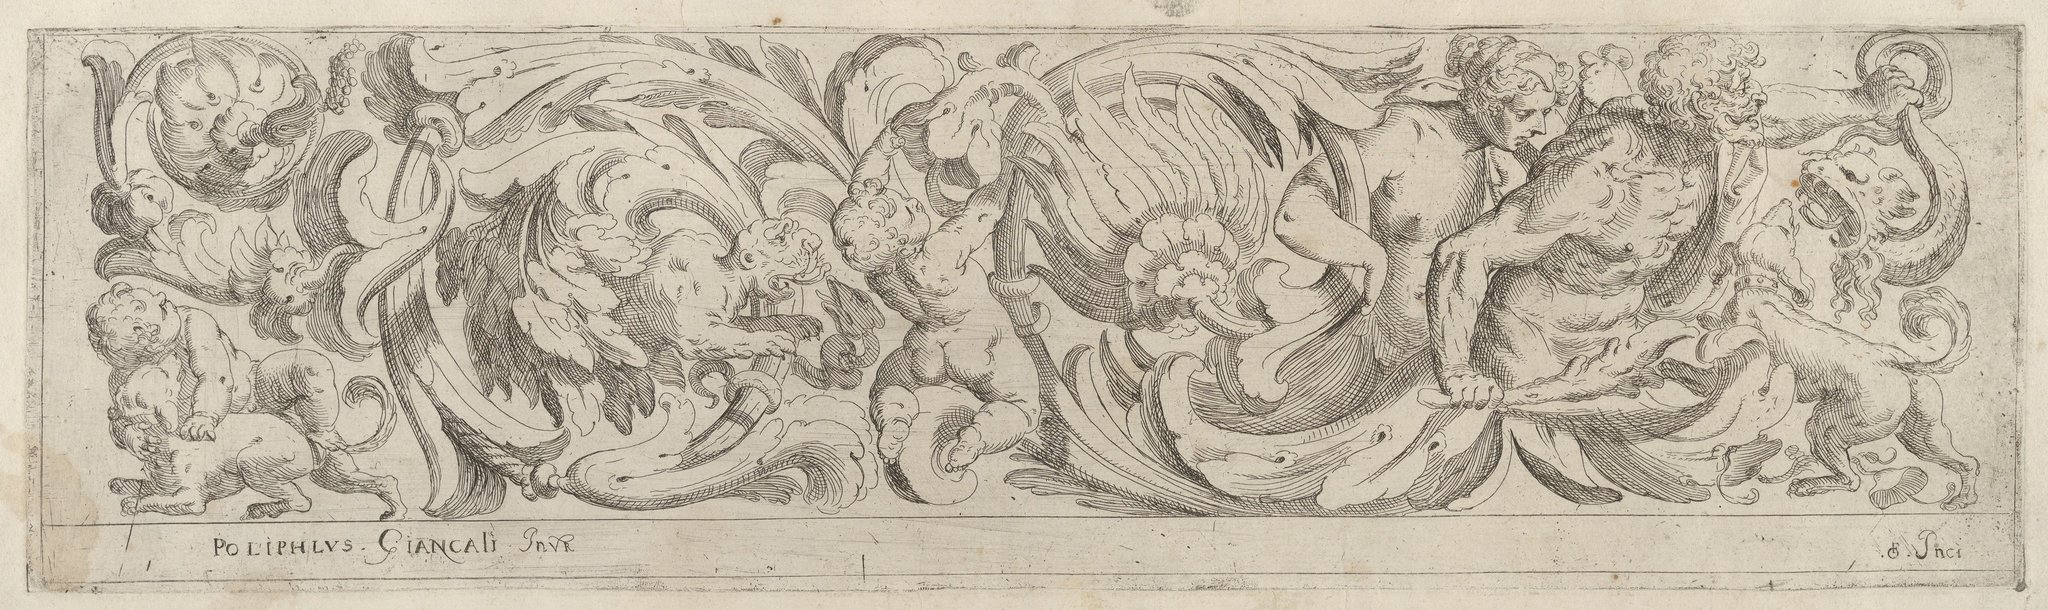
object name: collection ornament architecture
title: Disegni Varij di Polifilo Zancarli (Friezes)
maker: polifilo giancarli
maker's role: artist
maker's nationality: italian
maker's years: 1600-1625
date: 1625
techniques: etching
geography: italy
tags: dogs,snakes,acanthus